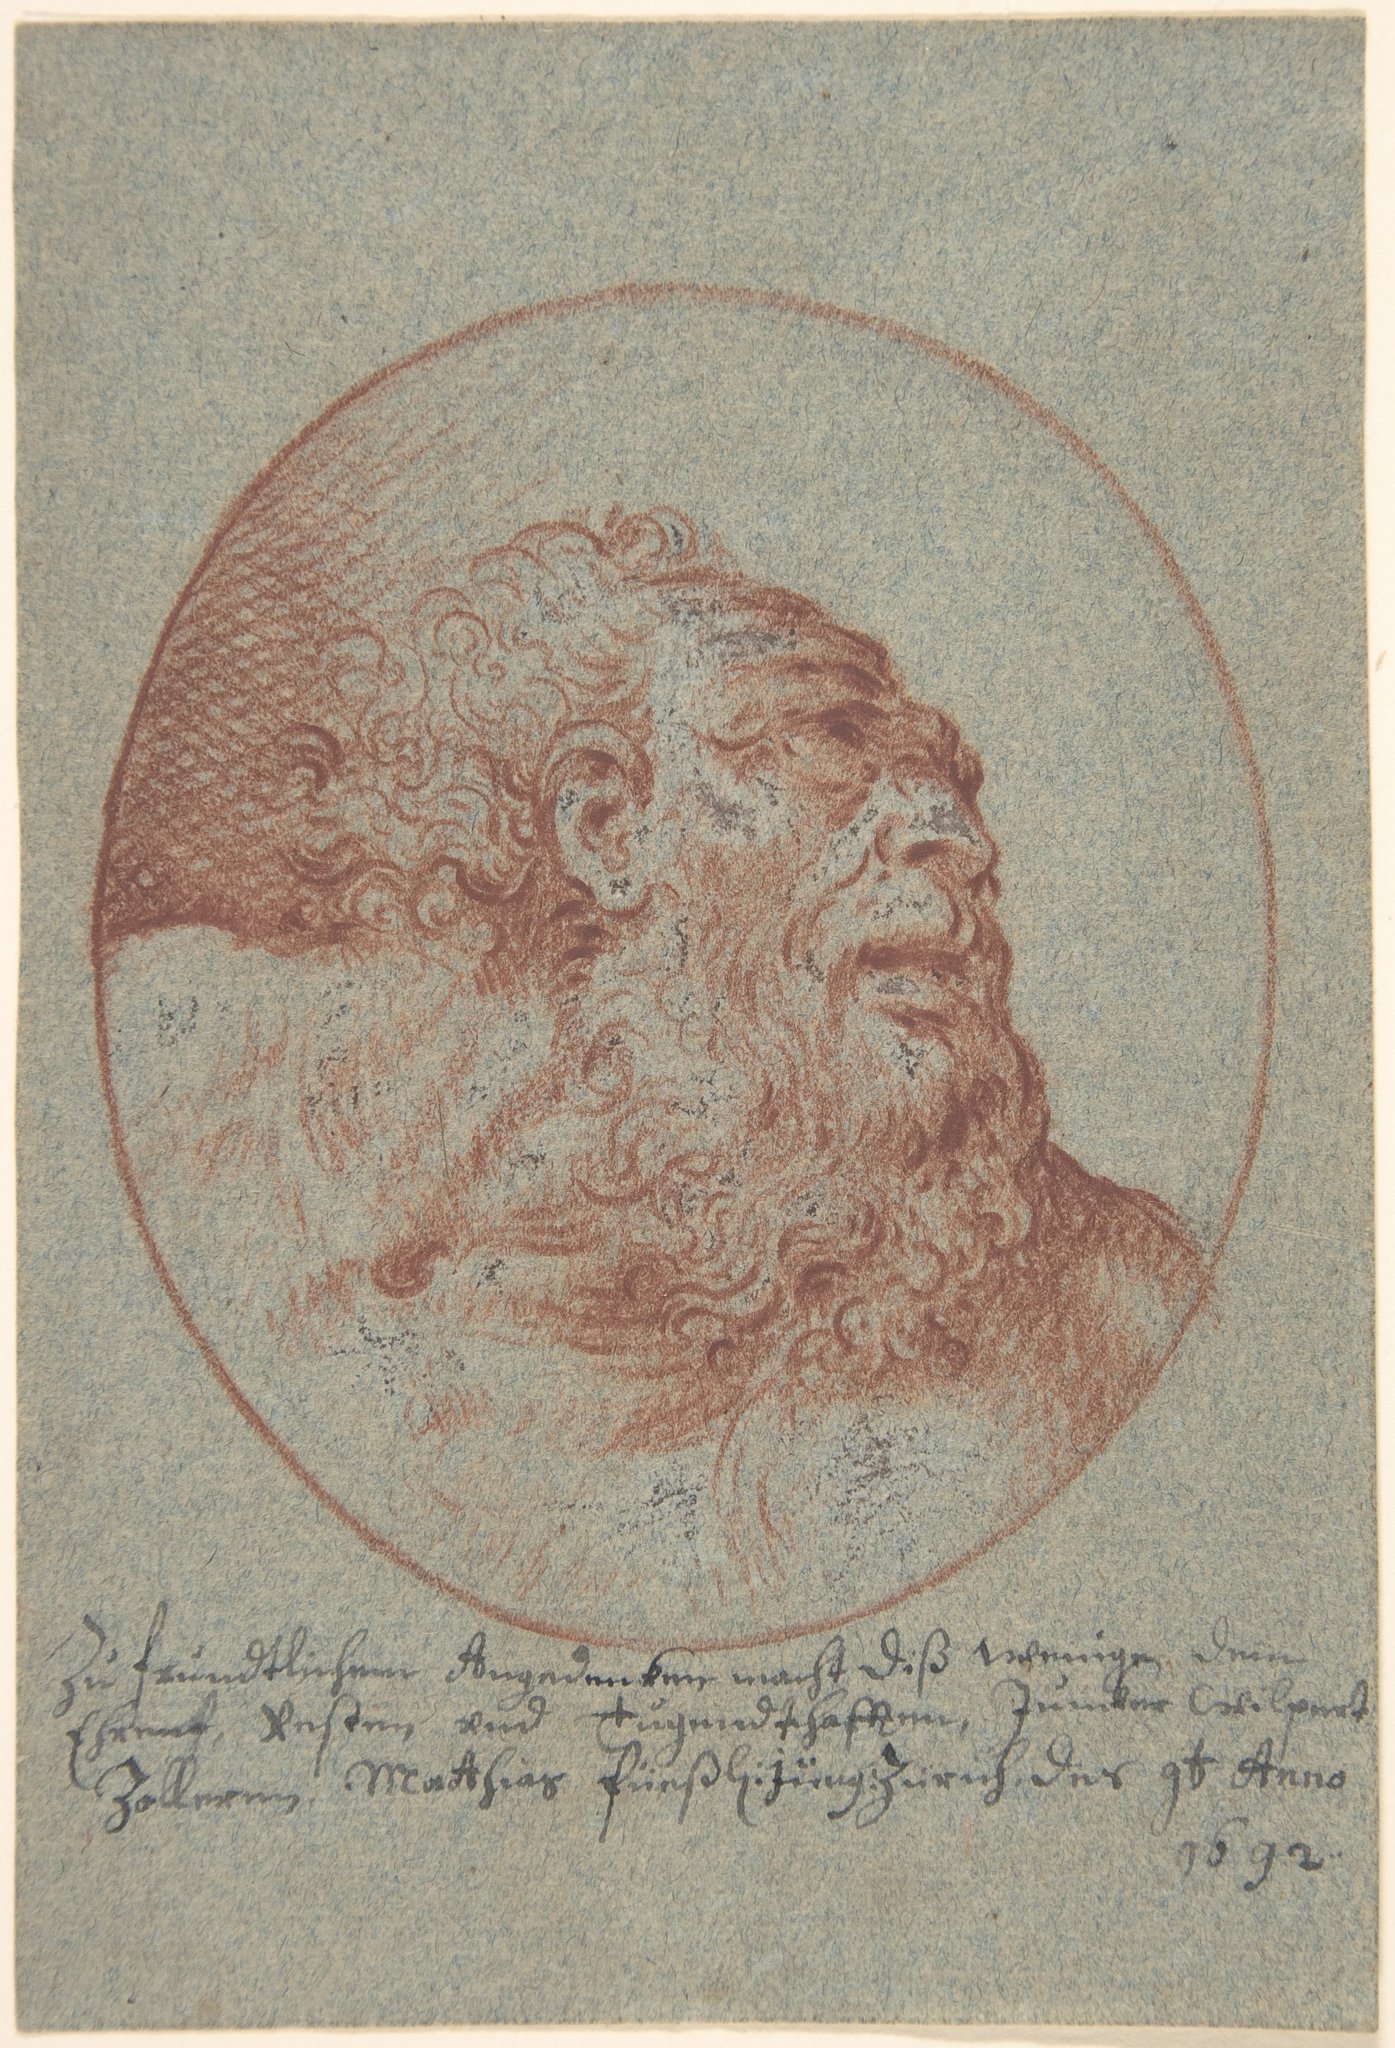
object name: drawing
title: Head of a Bearded Man Looking Right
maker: mathais füssli the youngest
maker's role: artist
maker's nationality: swiss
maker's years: 1671-1739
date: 1692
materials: chalk, gouache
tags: heads,men